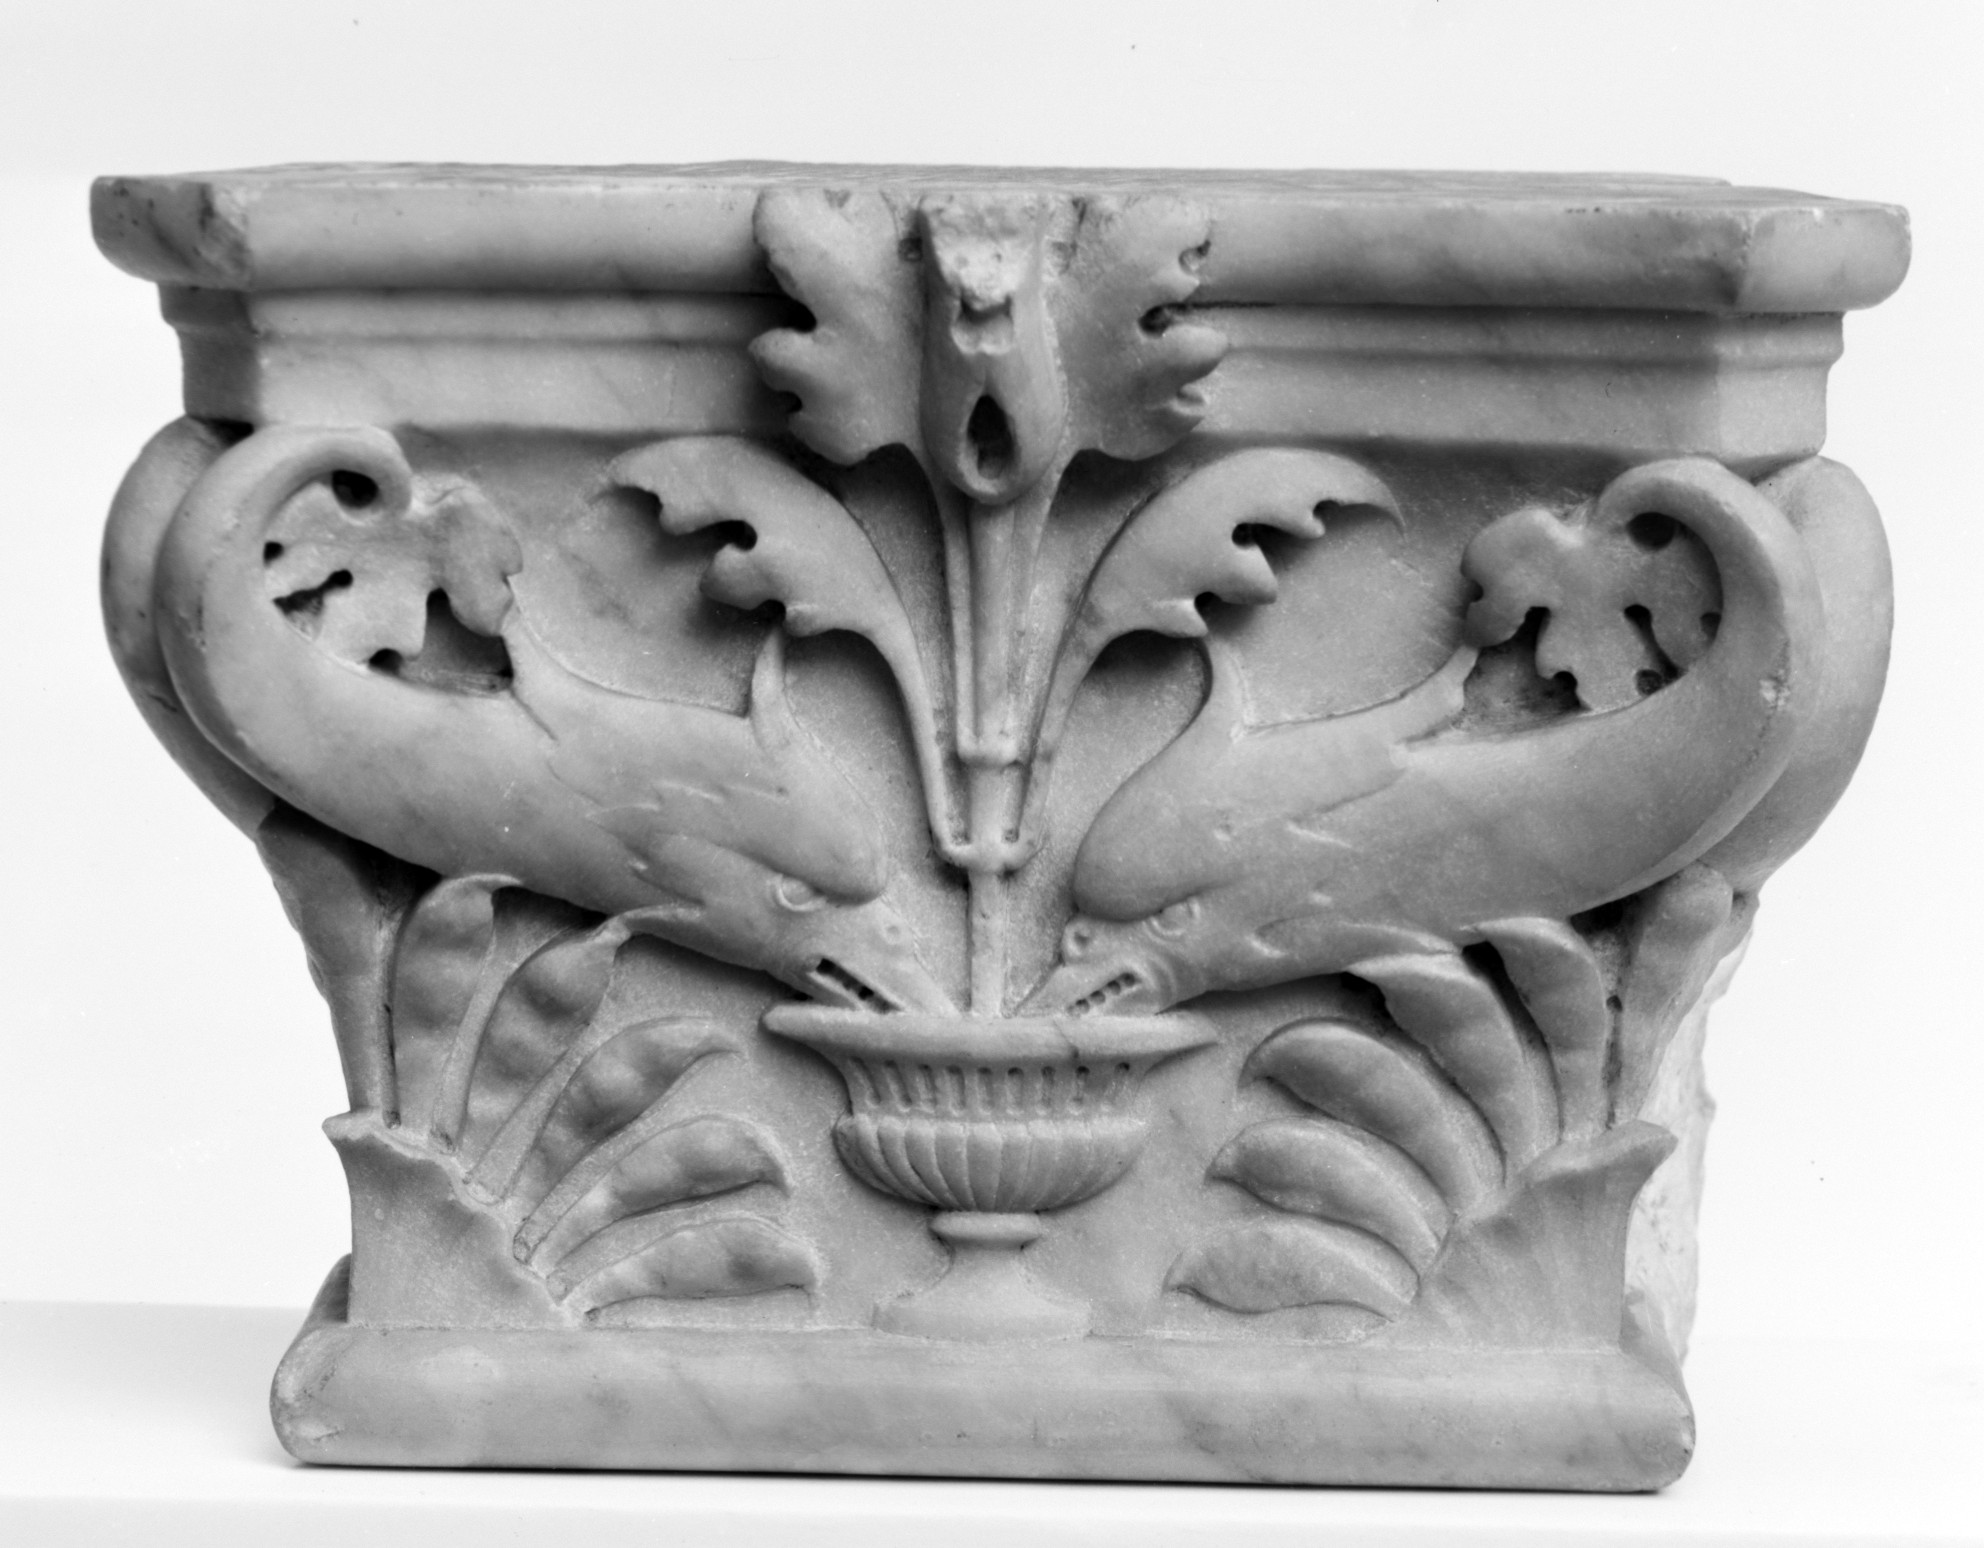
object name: capital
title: Pilaster capital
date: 1467-1533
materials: marble